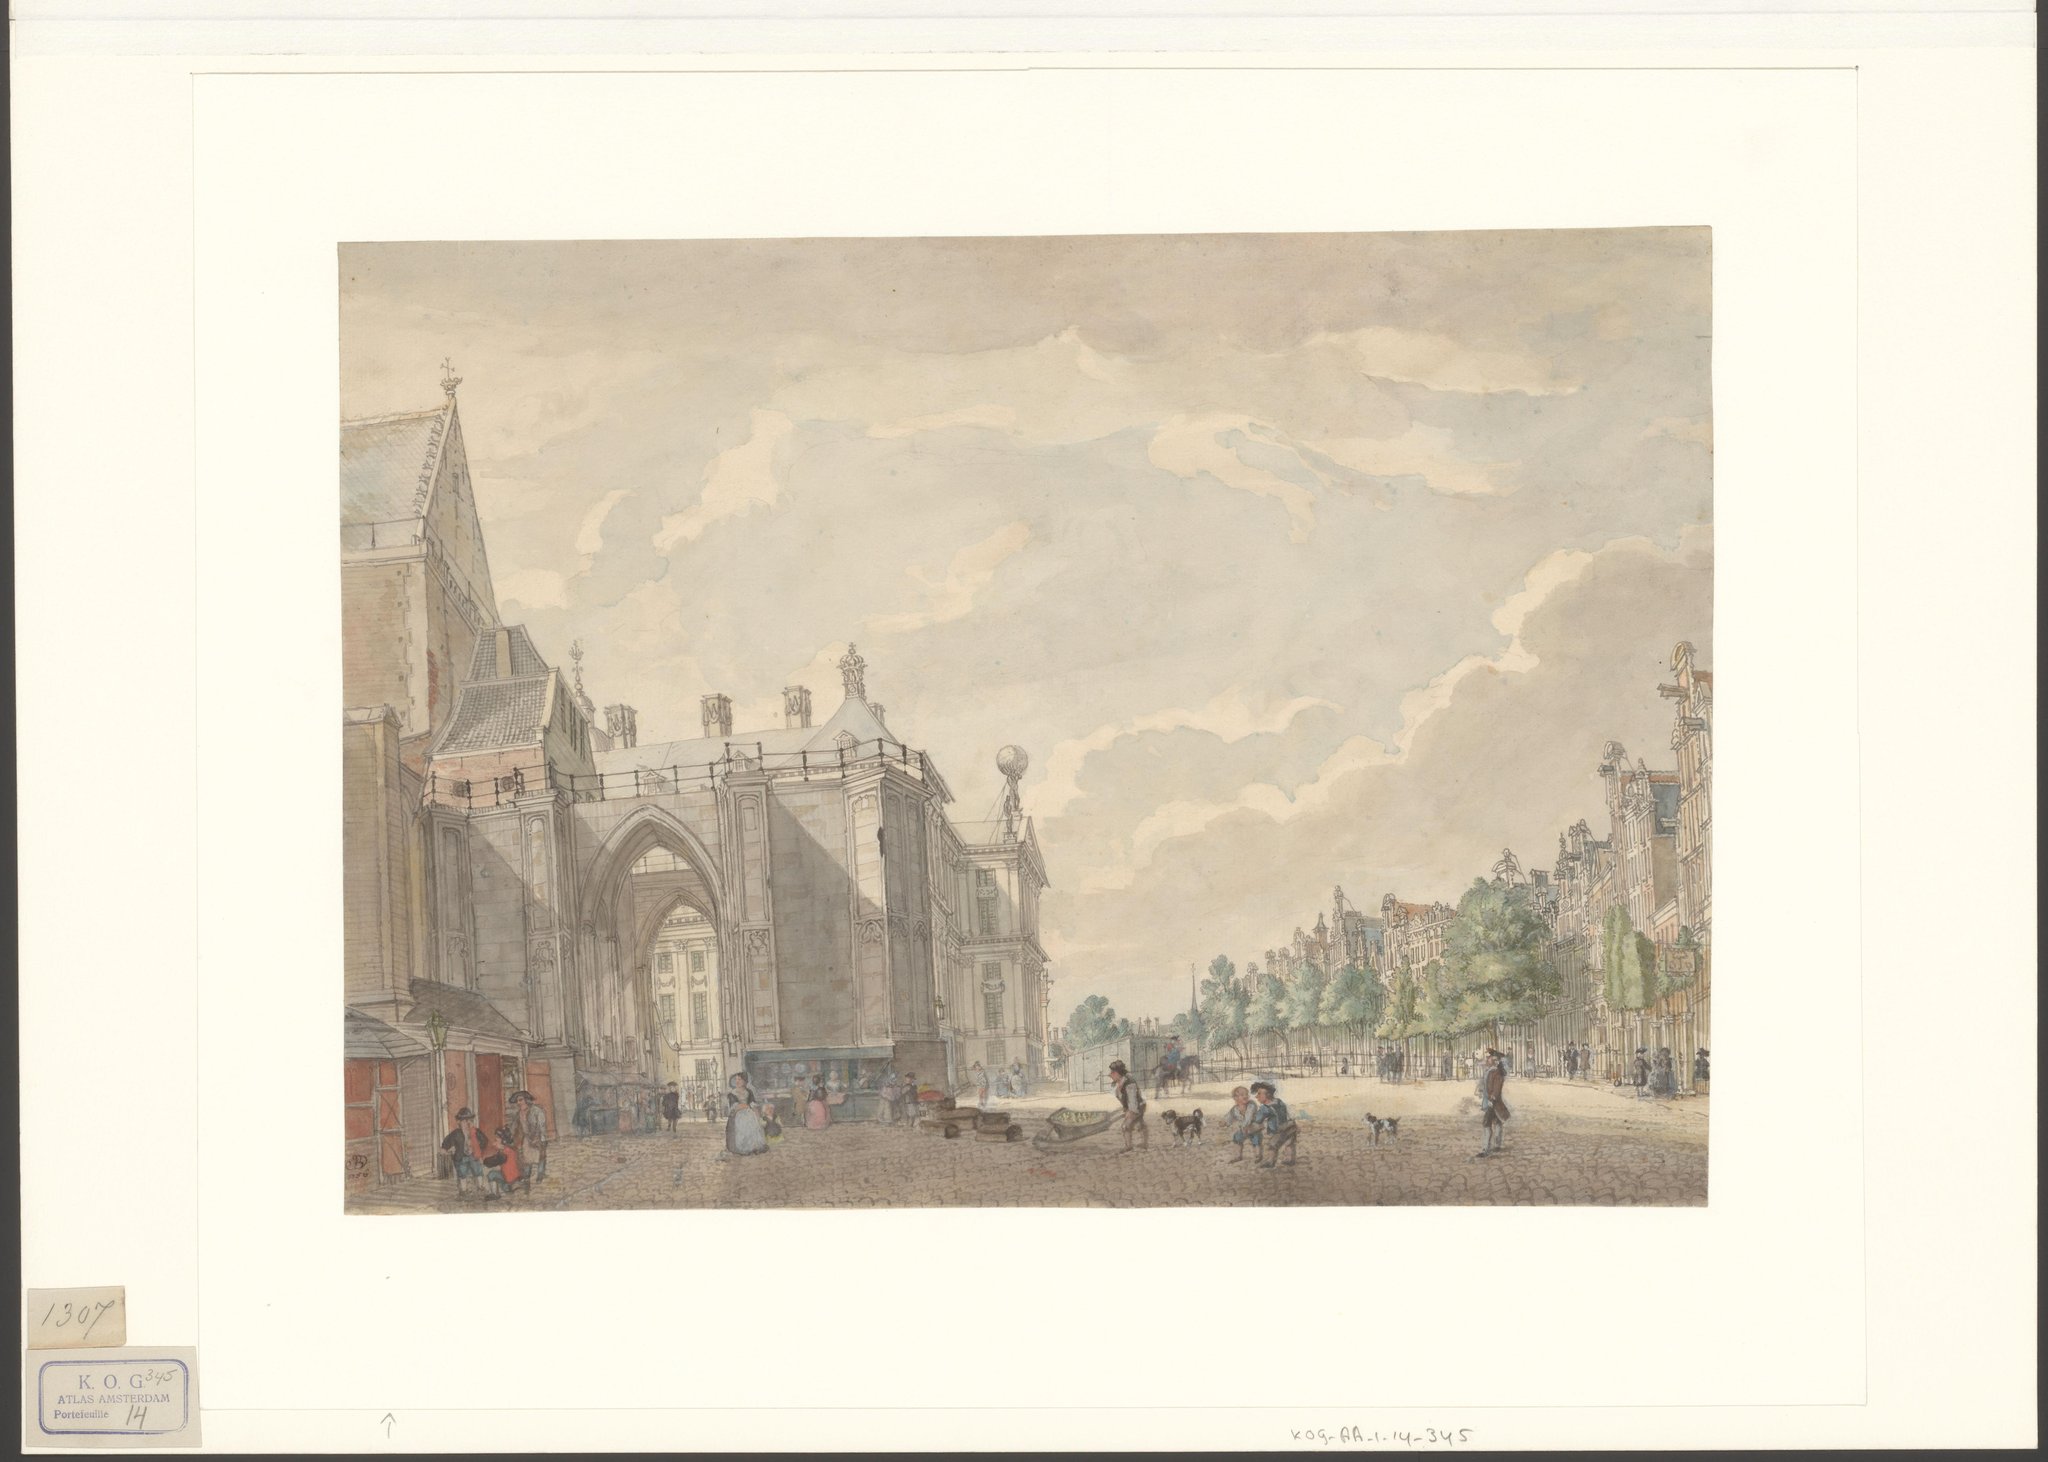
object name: drawing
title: Gezicht op de Nieuwe Kerk en het stadhuis aan de Nieuwezijds Voorburgwal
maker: jan spaan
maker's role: print maker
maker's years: 1742-1828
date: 1756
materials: paint, ink, paper, pencil, watercolor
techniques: brush, pen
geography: amsterdam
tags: city-view in general; 'veduta', church (exterior), townhall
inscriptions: inscription: ‘Port. 14 - 345’, inscription: ‘H.L.R. / 30’, collector's mark: ‘14’ Lugt 1641b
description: Onderwerpsrubriek binnen de Atlas Amsterdam: Verhulststraat (Johannes), Viaducten, Vierwindenstraat, Vinkenbuurt, Vinkenpad, Vinkenstraat, Vischsteeg, Vliegendesteeg, Voetboogstraat, Volewijk, Vondelstraat, Voorburgwal (N.Z.).